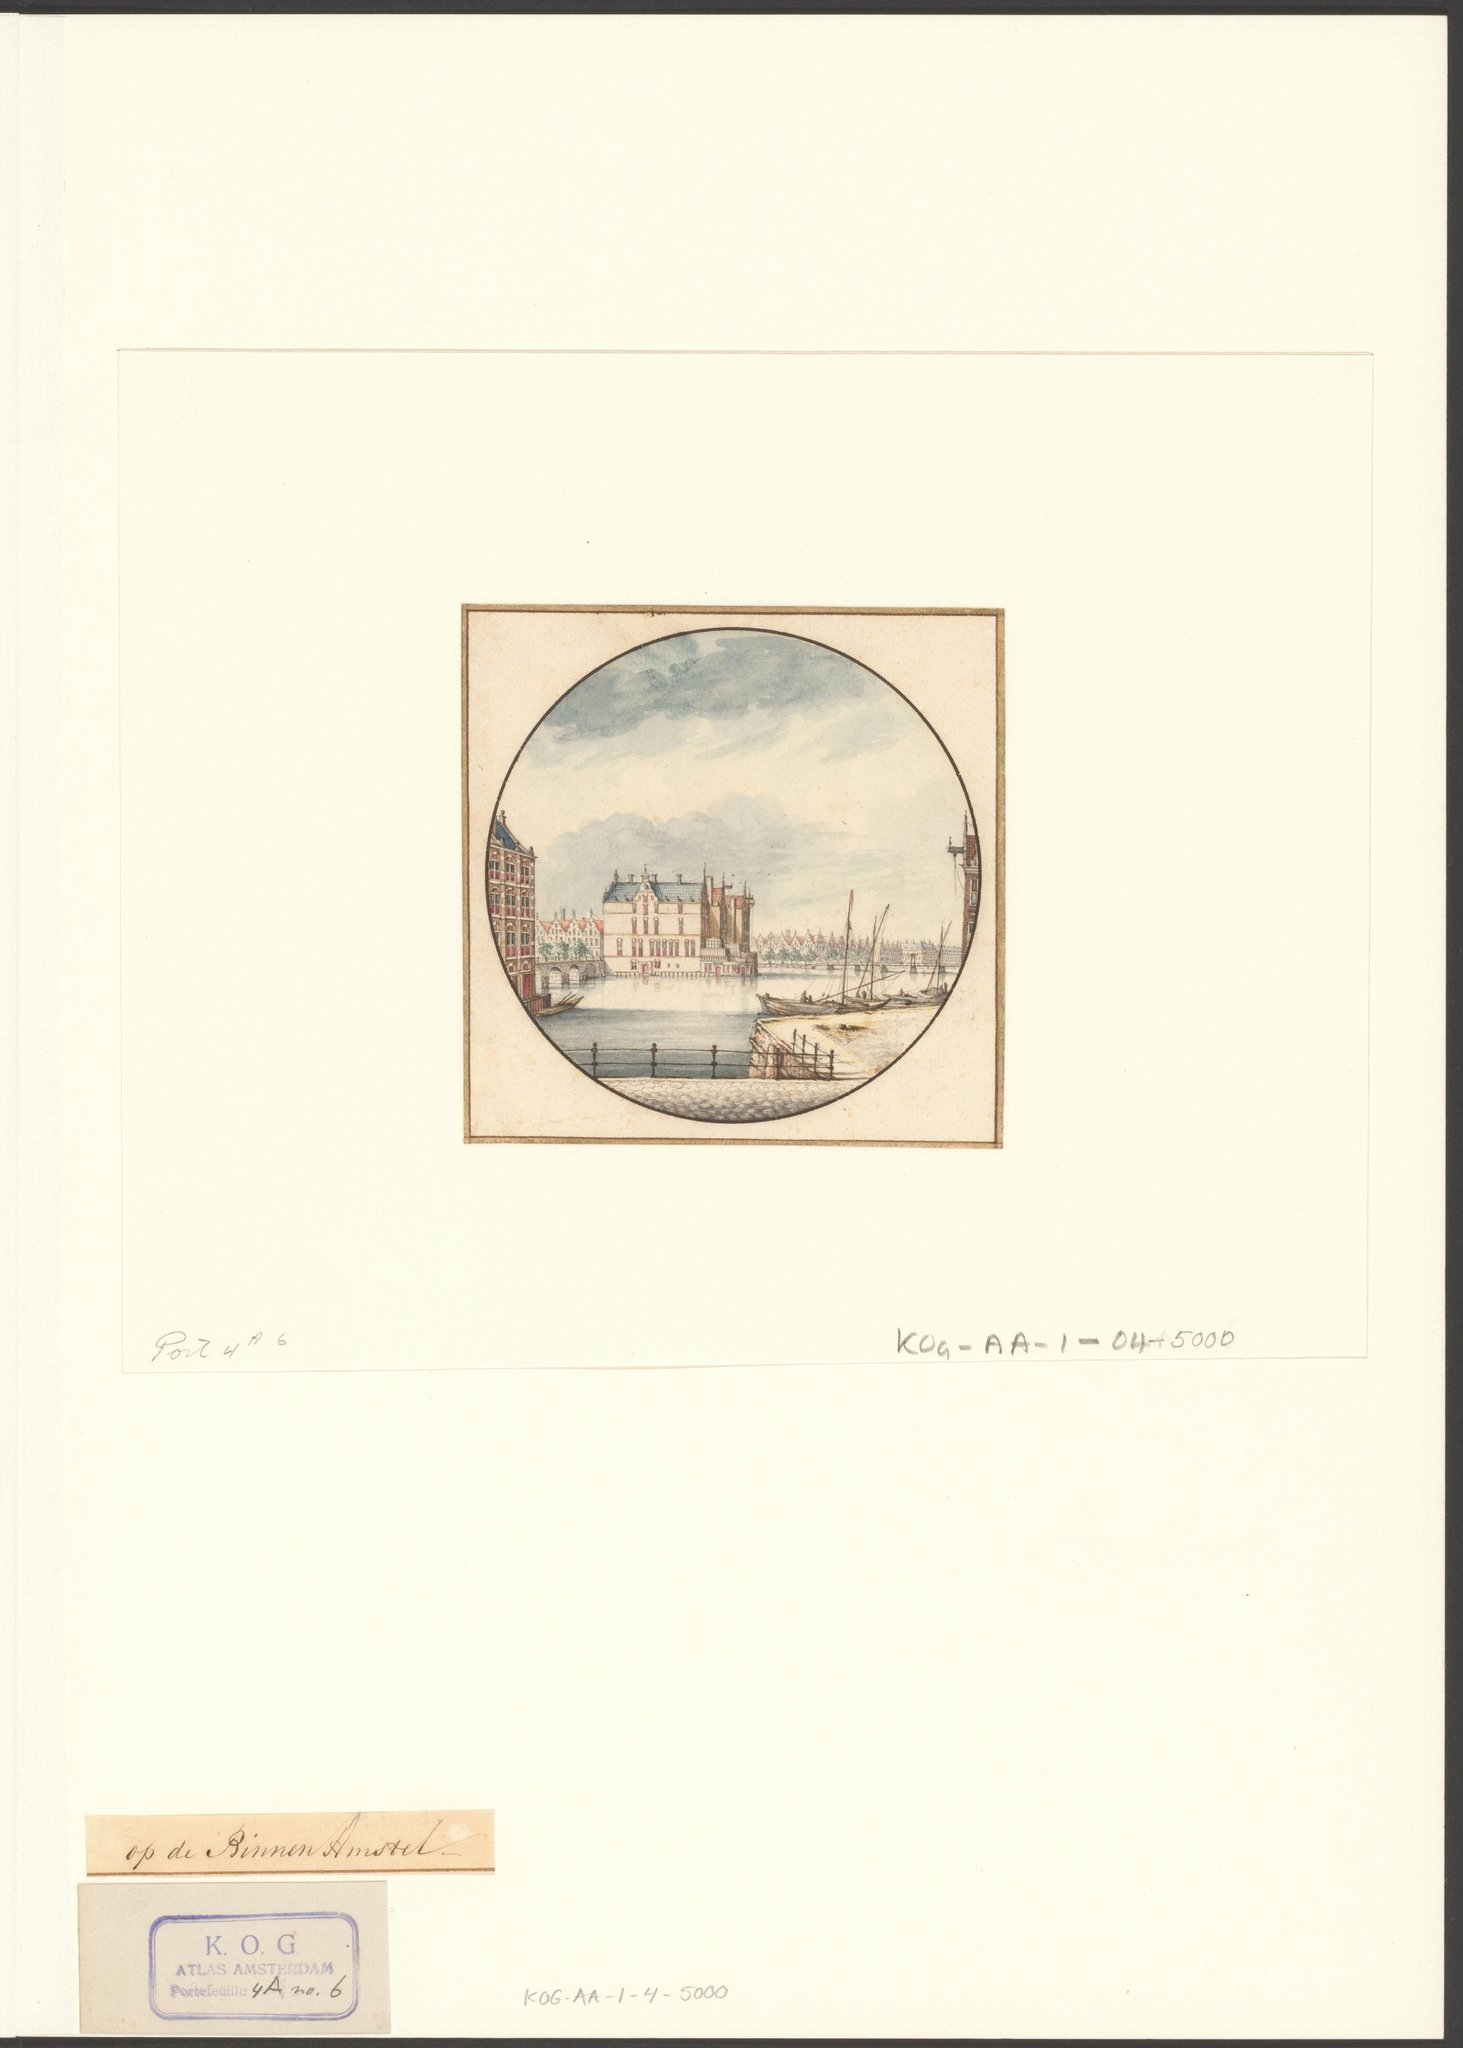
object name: drawing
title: Gezicht op de Amstel gezien vanaf de Munt naar de Halvemaansbrug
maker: jan van call (i)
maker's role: draughtsman, print maker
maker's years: 1656-1706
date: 1666-1703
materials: paint, ink, paper, pencil, watercolor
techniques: brush, pen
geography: amsterdam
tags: city-view in general; 'veduta', river, bridge in city across river, canal, etc.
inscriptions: inscription: ‘Port. 4A6’, collector's mark: ‘4A’ Lugt 1641b, inscription: ‘op de BinnenAmstel.’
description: Onderwerpsrubriek binnen de Atlas Amsterdam: Amstel van Doelensluis tot Blauwbrug.